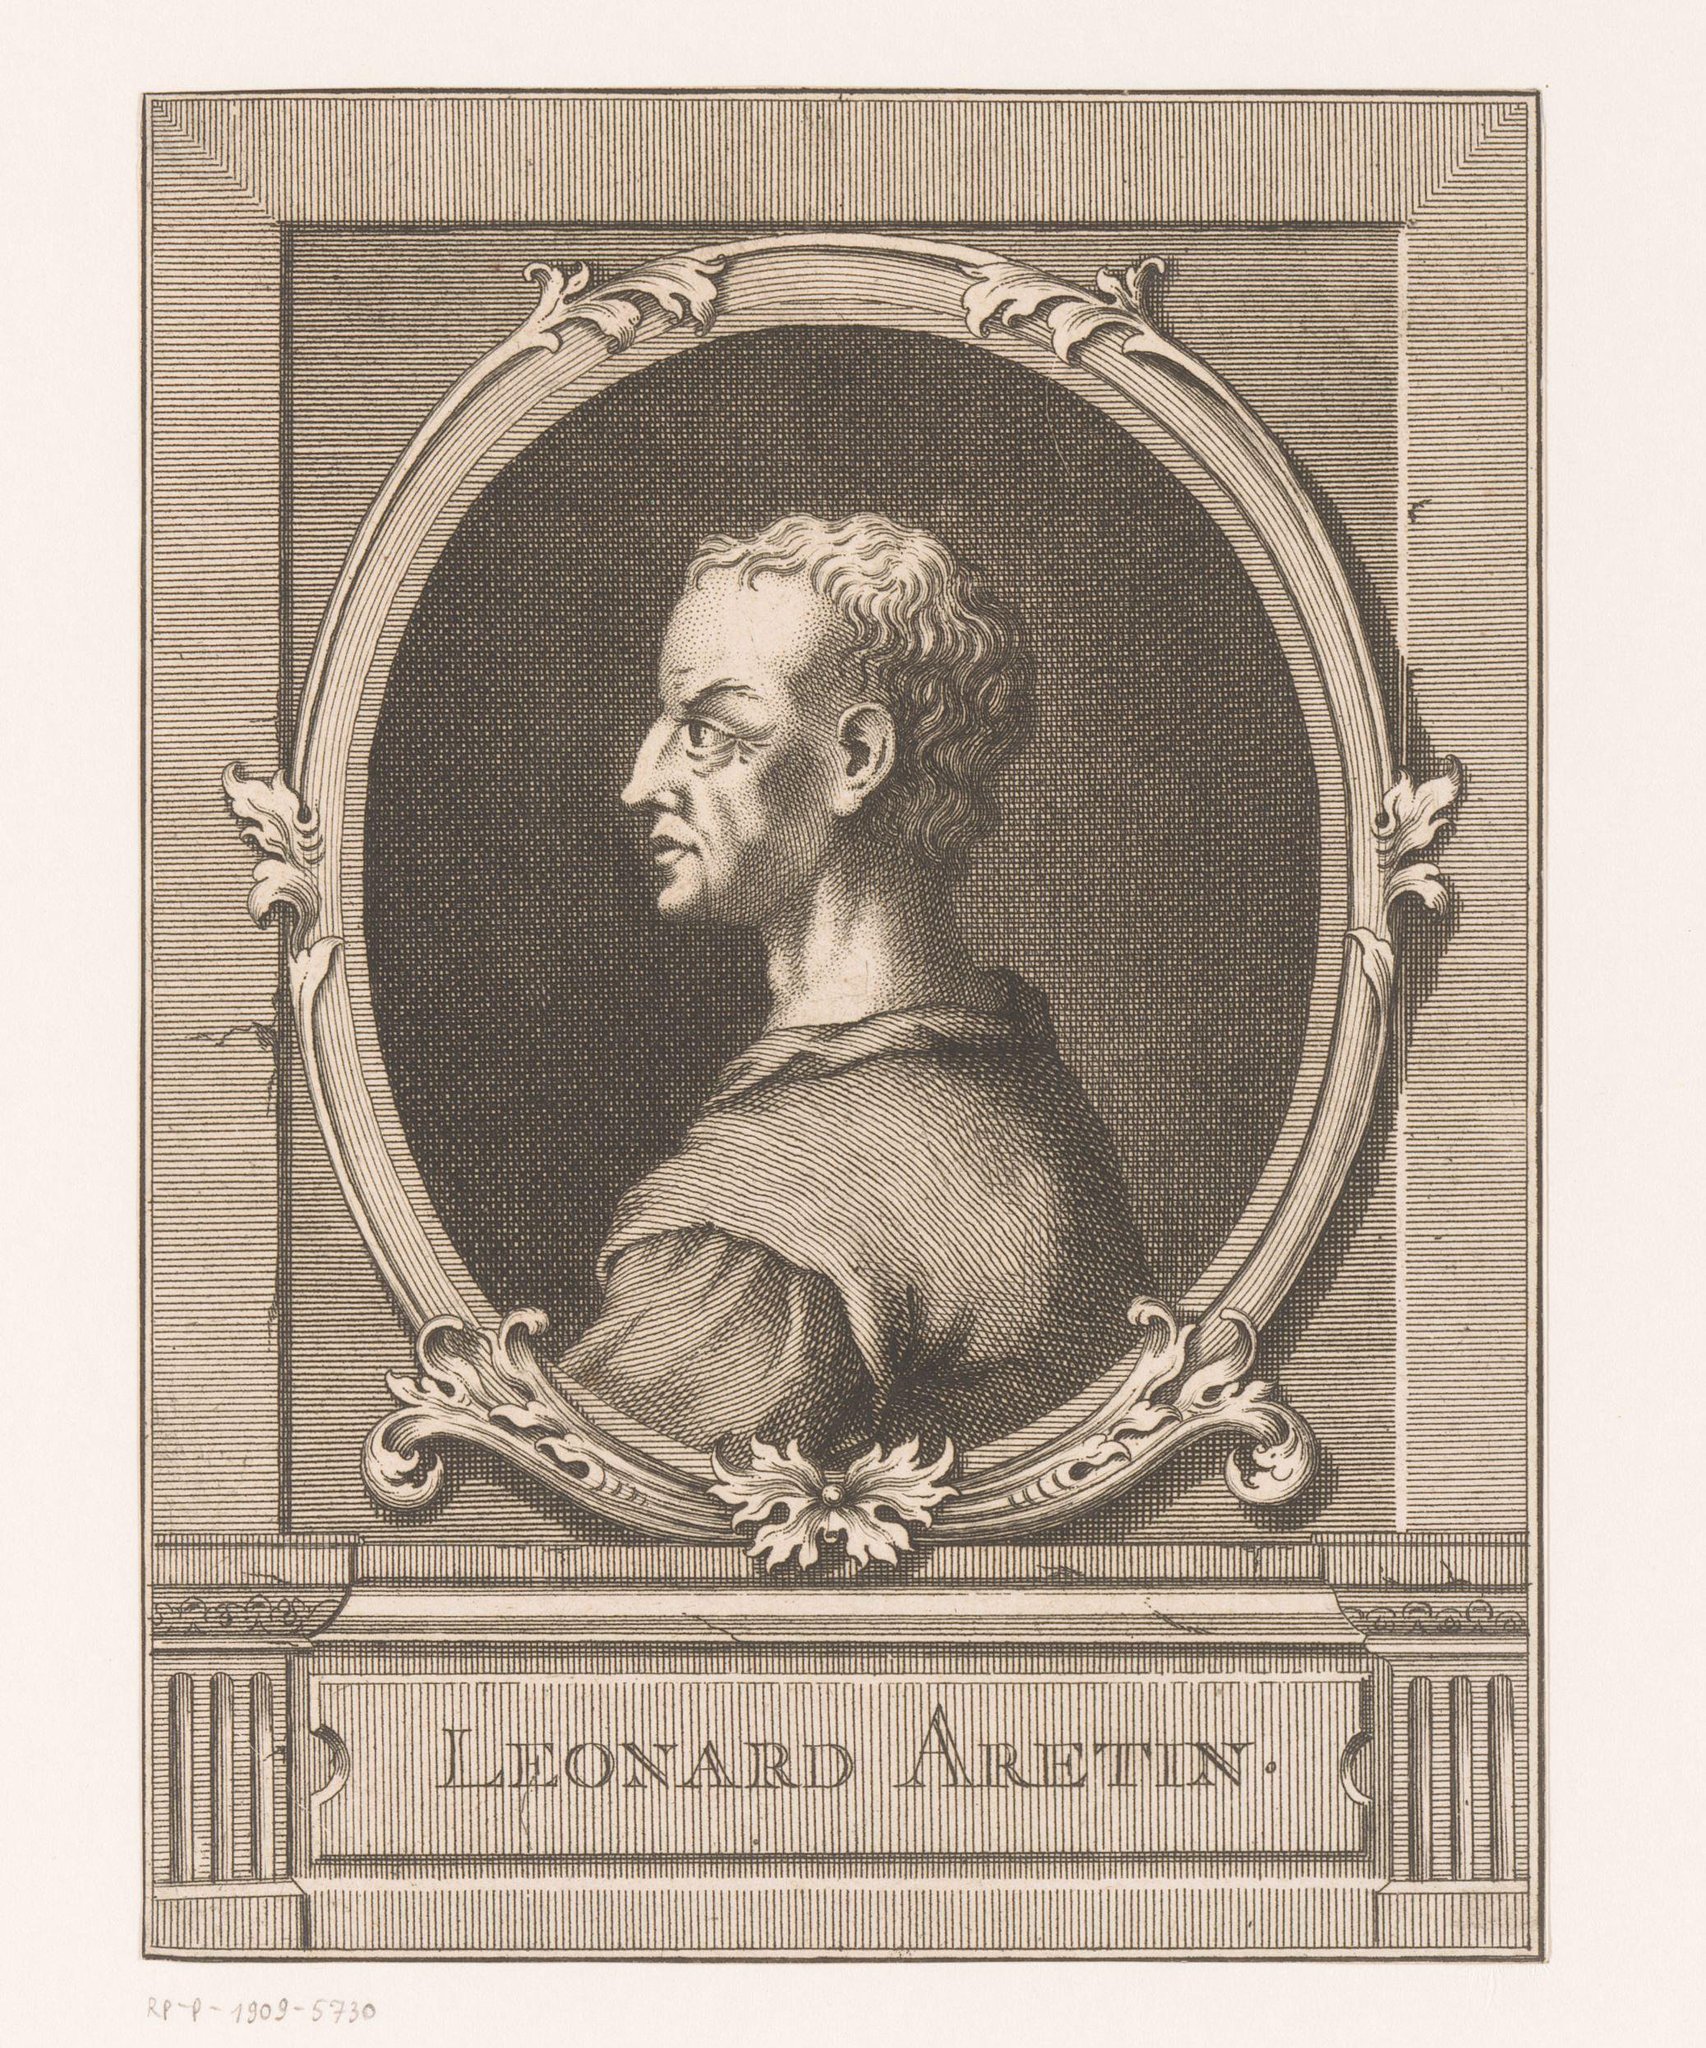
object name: print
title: Leonard Aretin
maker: c. mathey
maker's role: print maker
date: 1700-1755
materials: paper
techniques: engraving, etching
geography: france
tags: historical persons, politician, e.g. party leader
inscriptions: collector's mark: Lugt 2228